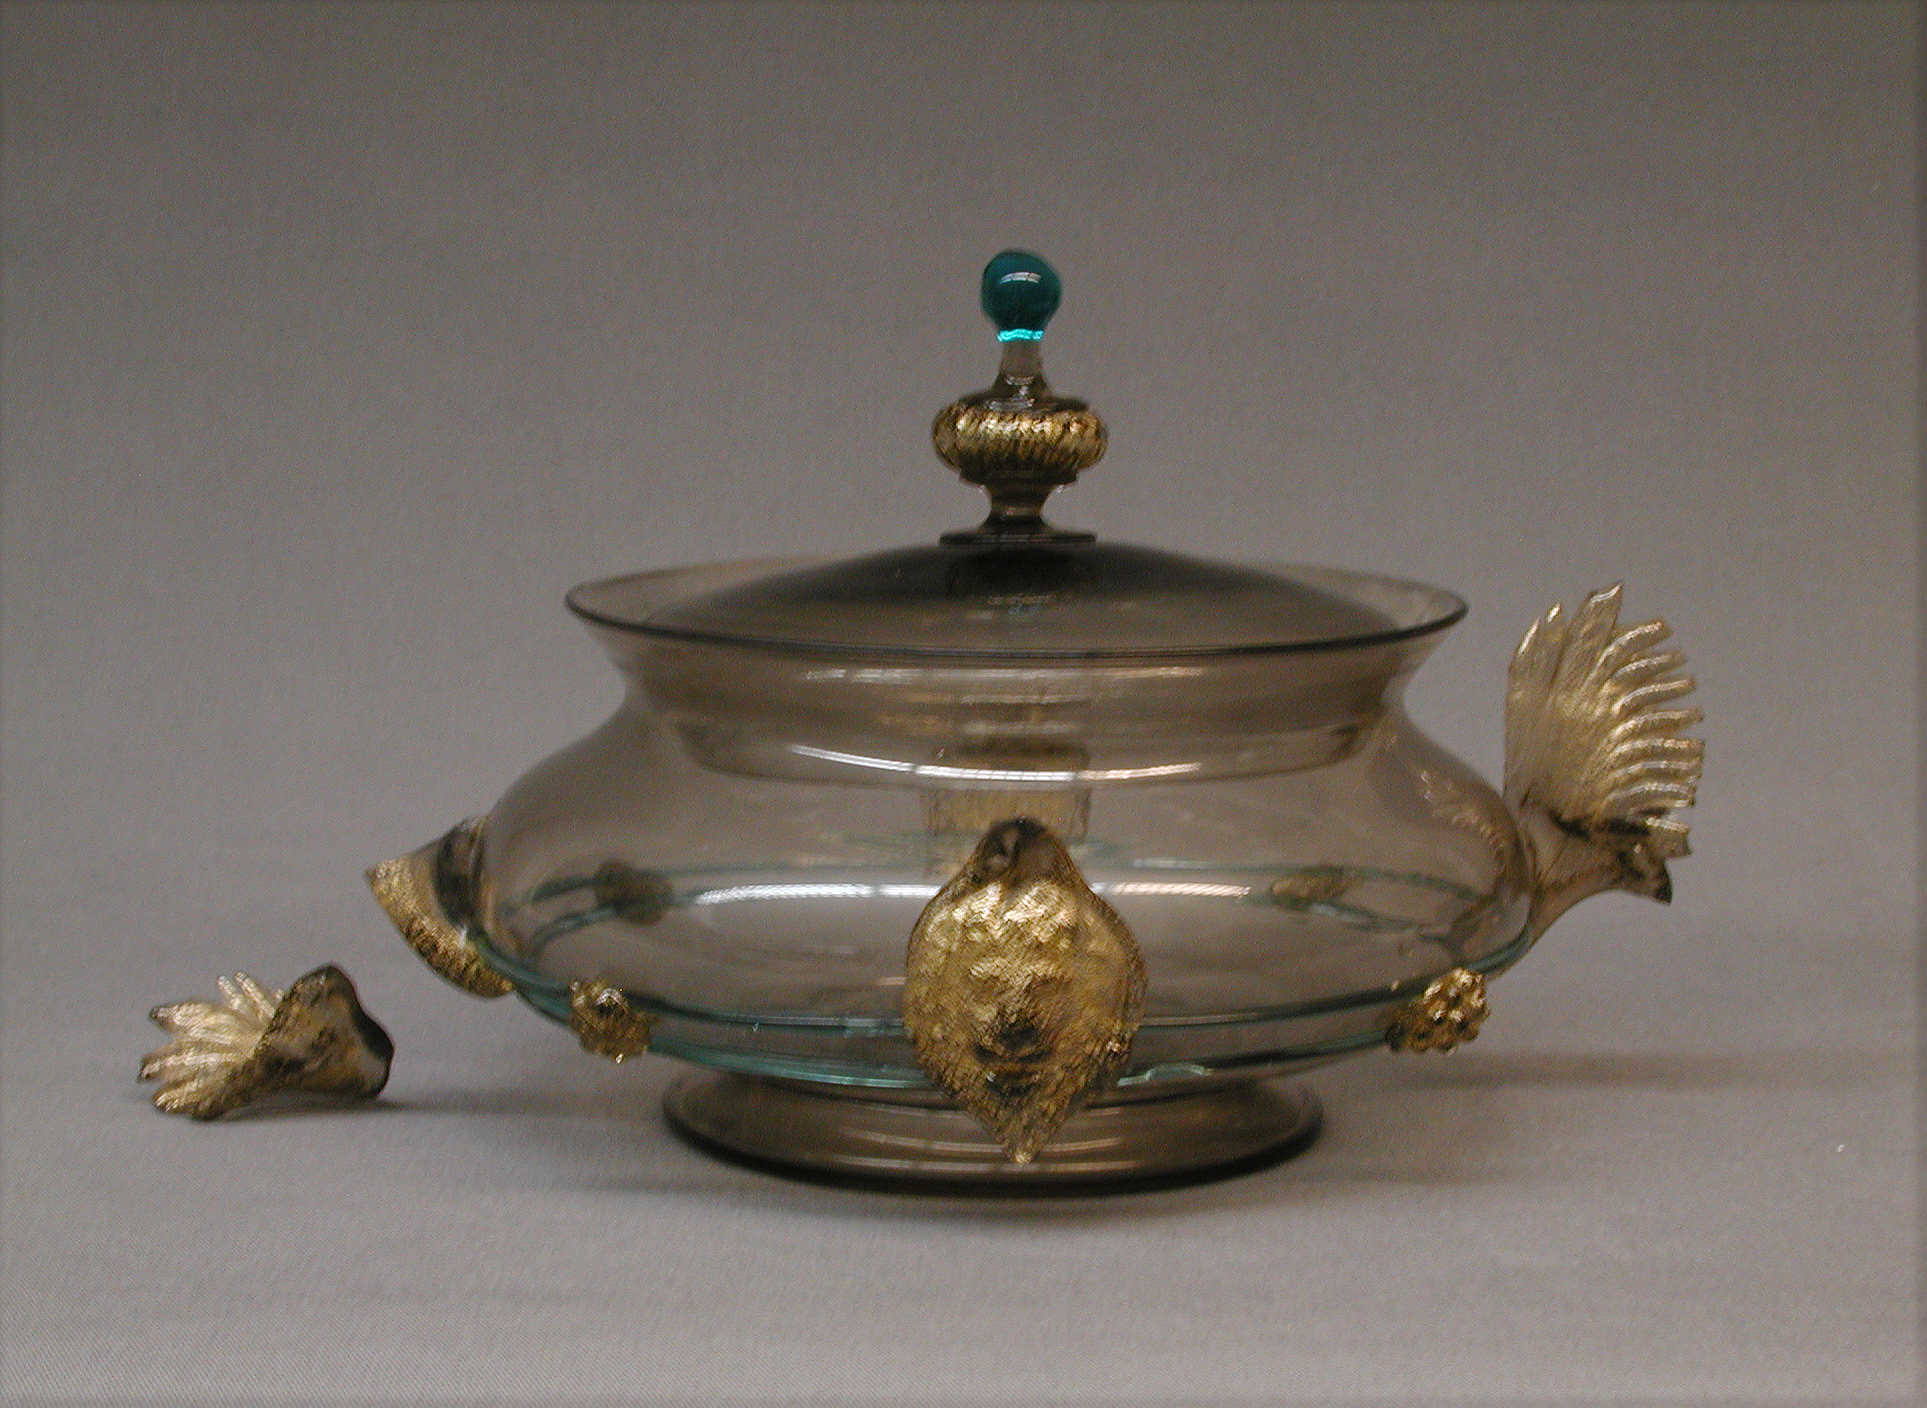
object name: bowl with cover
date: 1801-1900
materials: glass